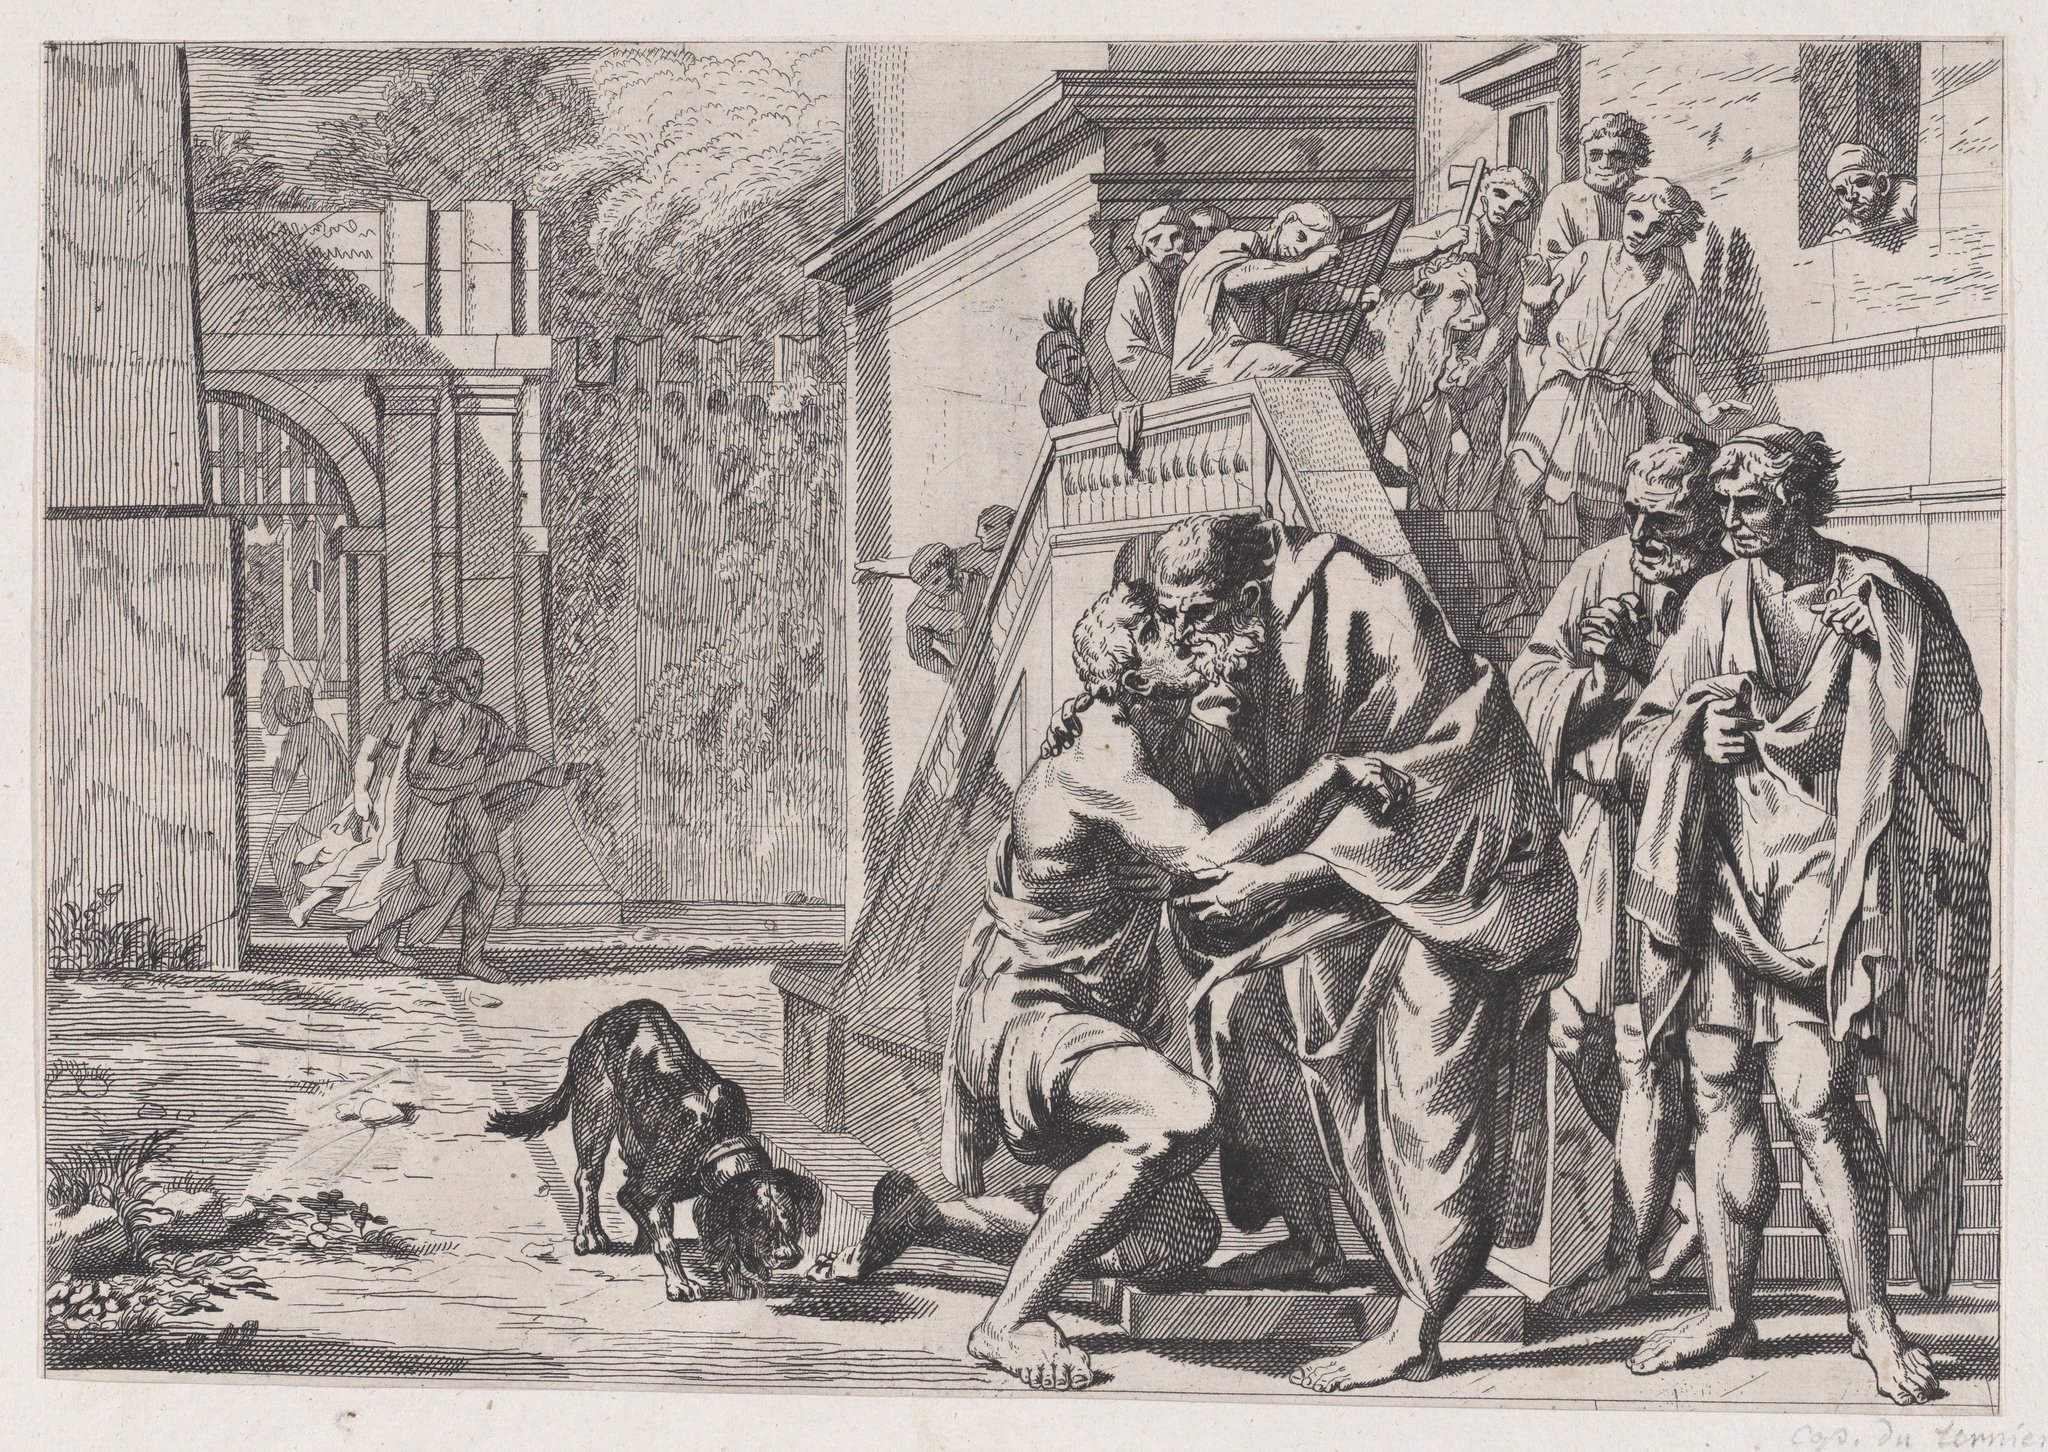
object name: print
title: The return of the Prodigal Son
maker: anonymous, 17th century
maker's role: artist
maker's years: 1600-1700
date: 1650-1700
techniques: etching